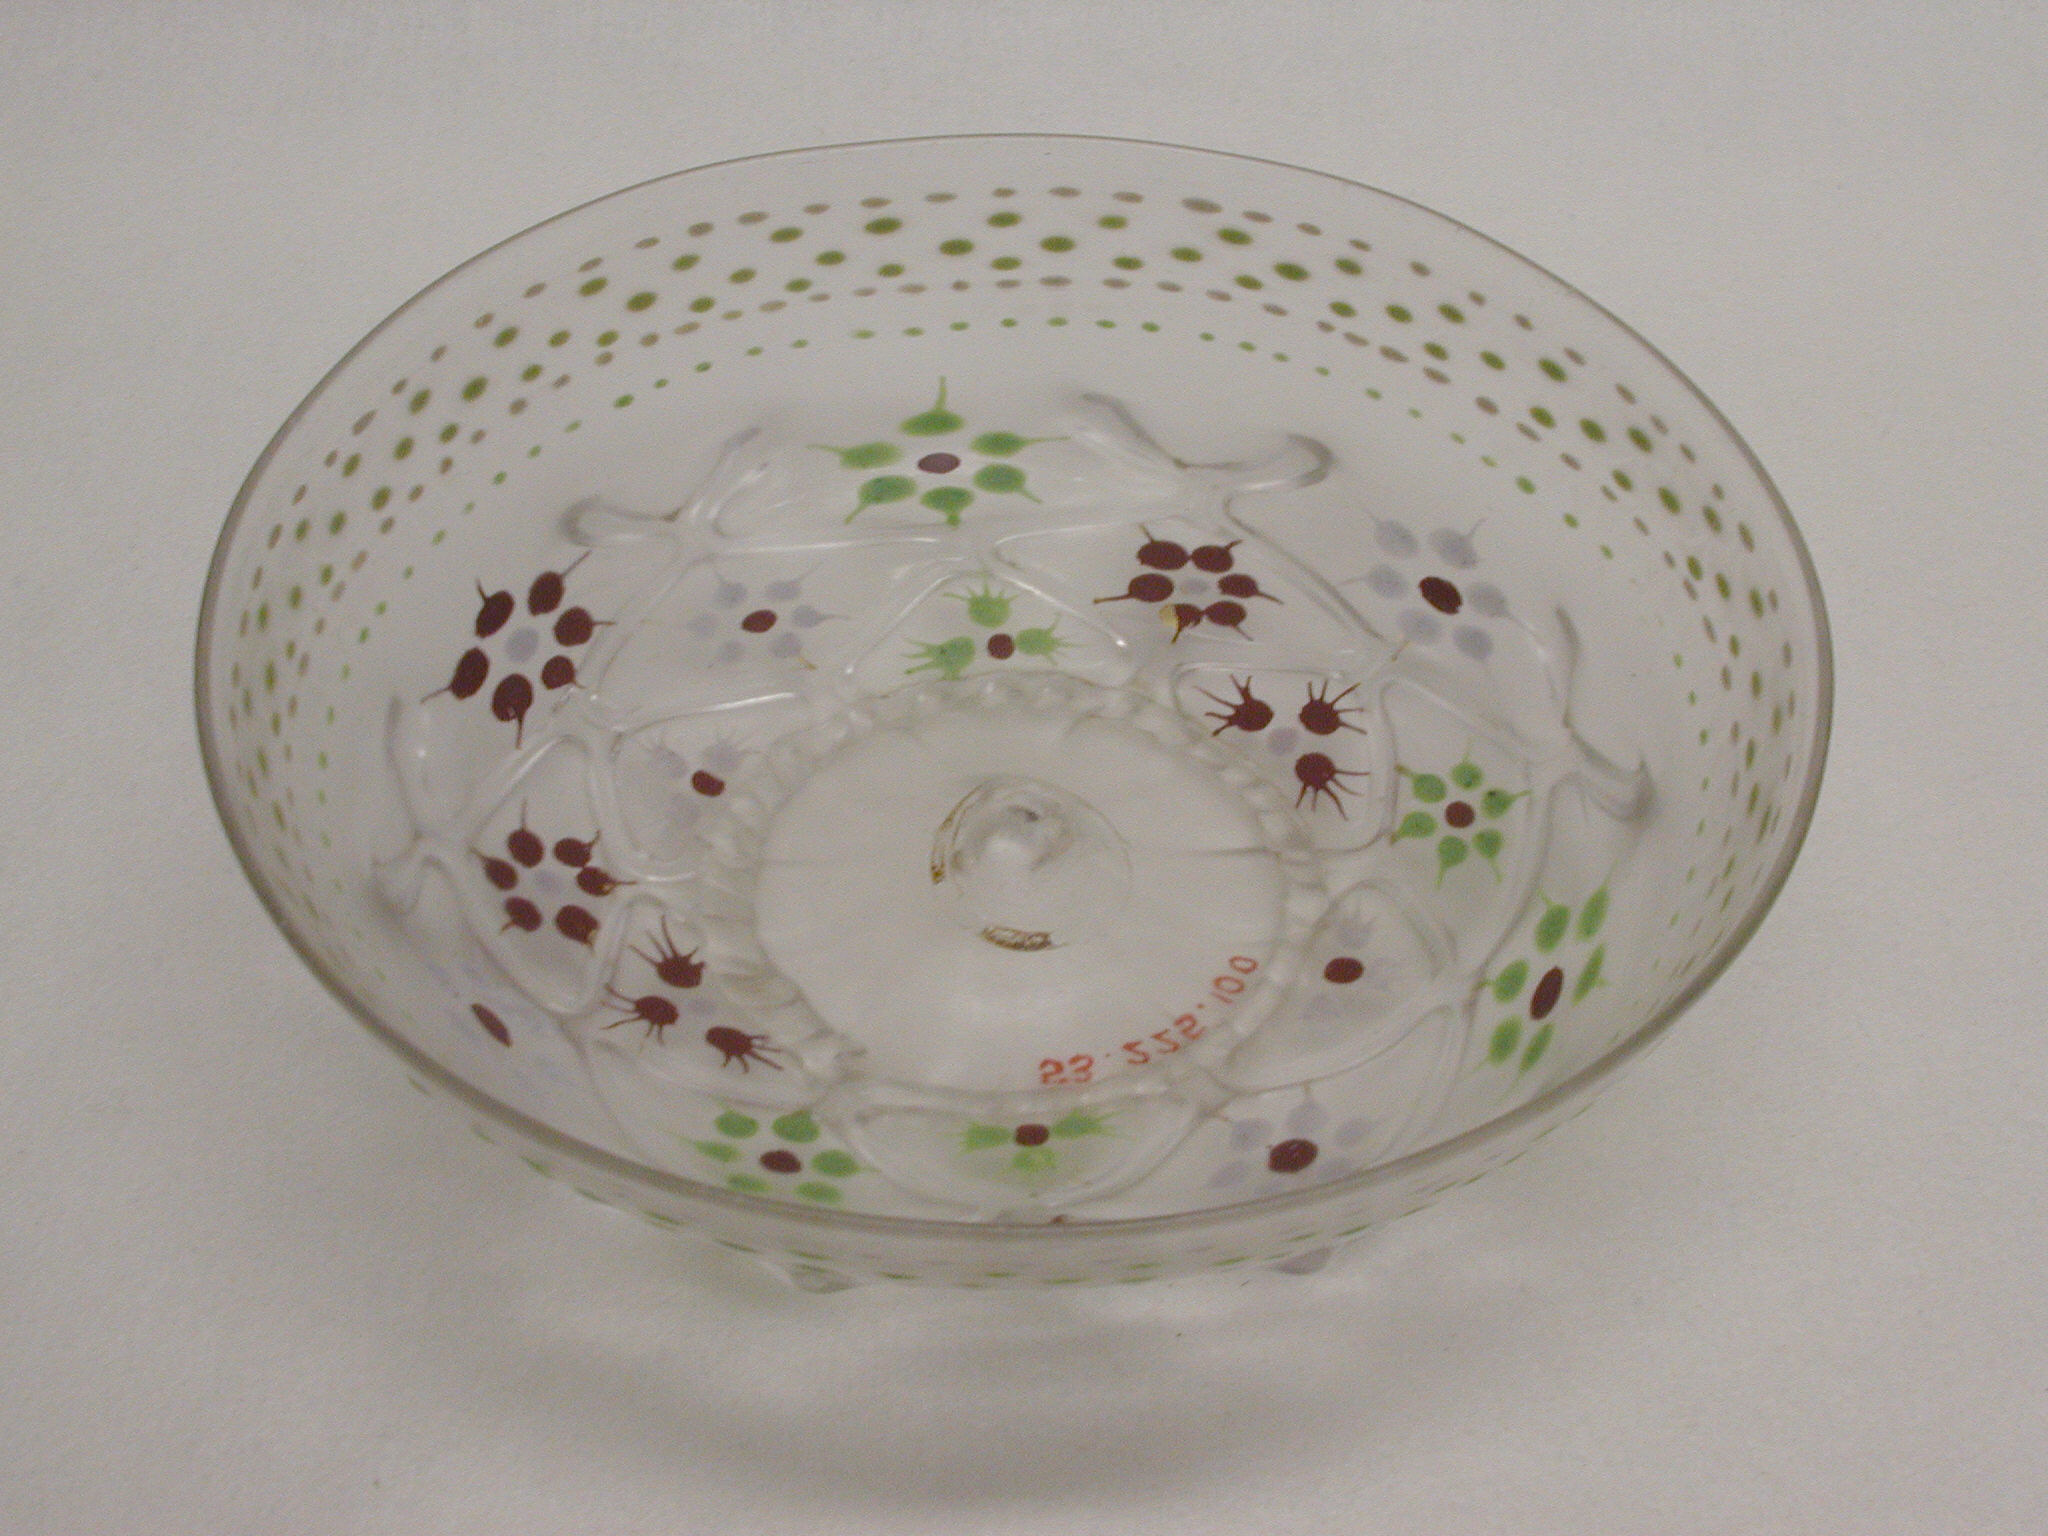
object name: bowl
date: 1467-1533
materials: glass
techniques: enamel